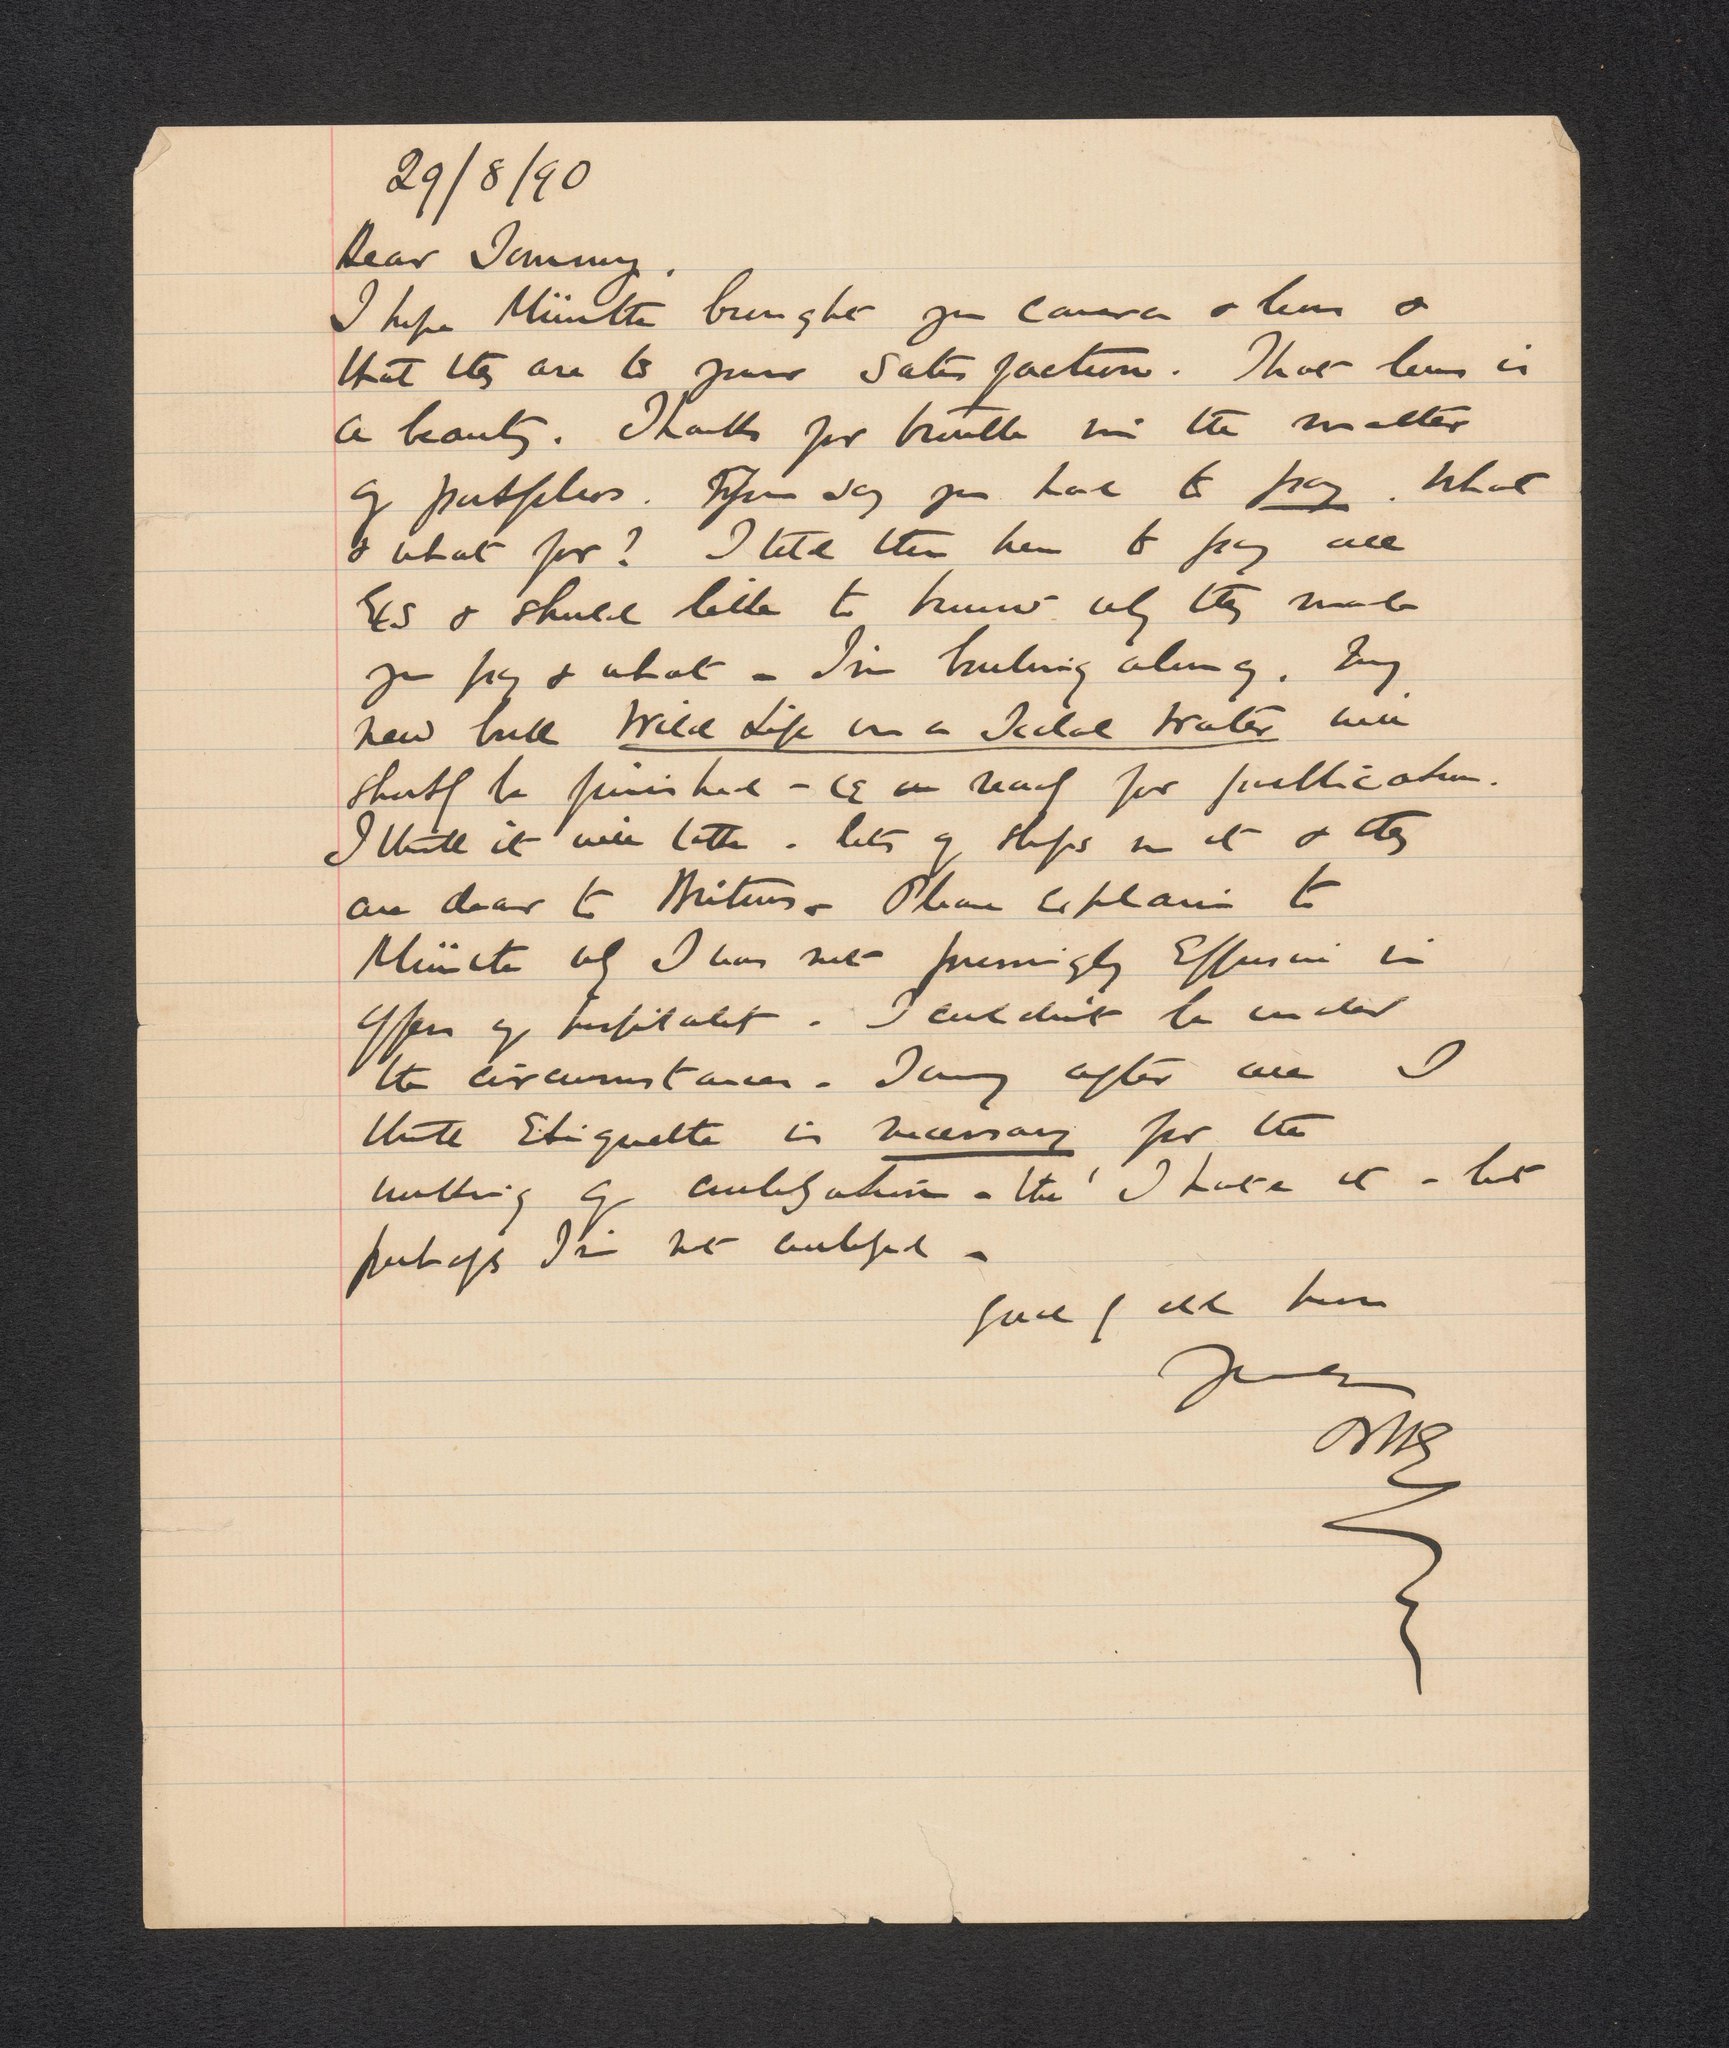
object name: letter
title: Brief aan Jimmy (James)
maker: peter henry emerson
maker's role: fotograaf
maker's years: 1856-1936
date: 1890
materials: ink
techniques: pen, writing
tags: photography, printed matter